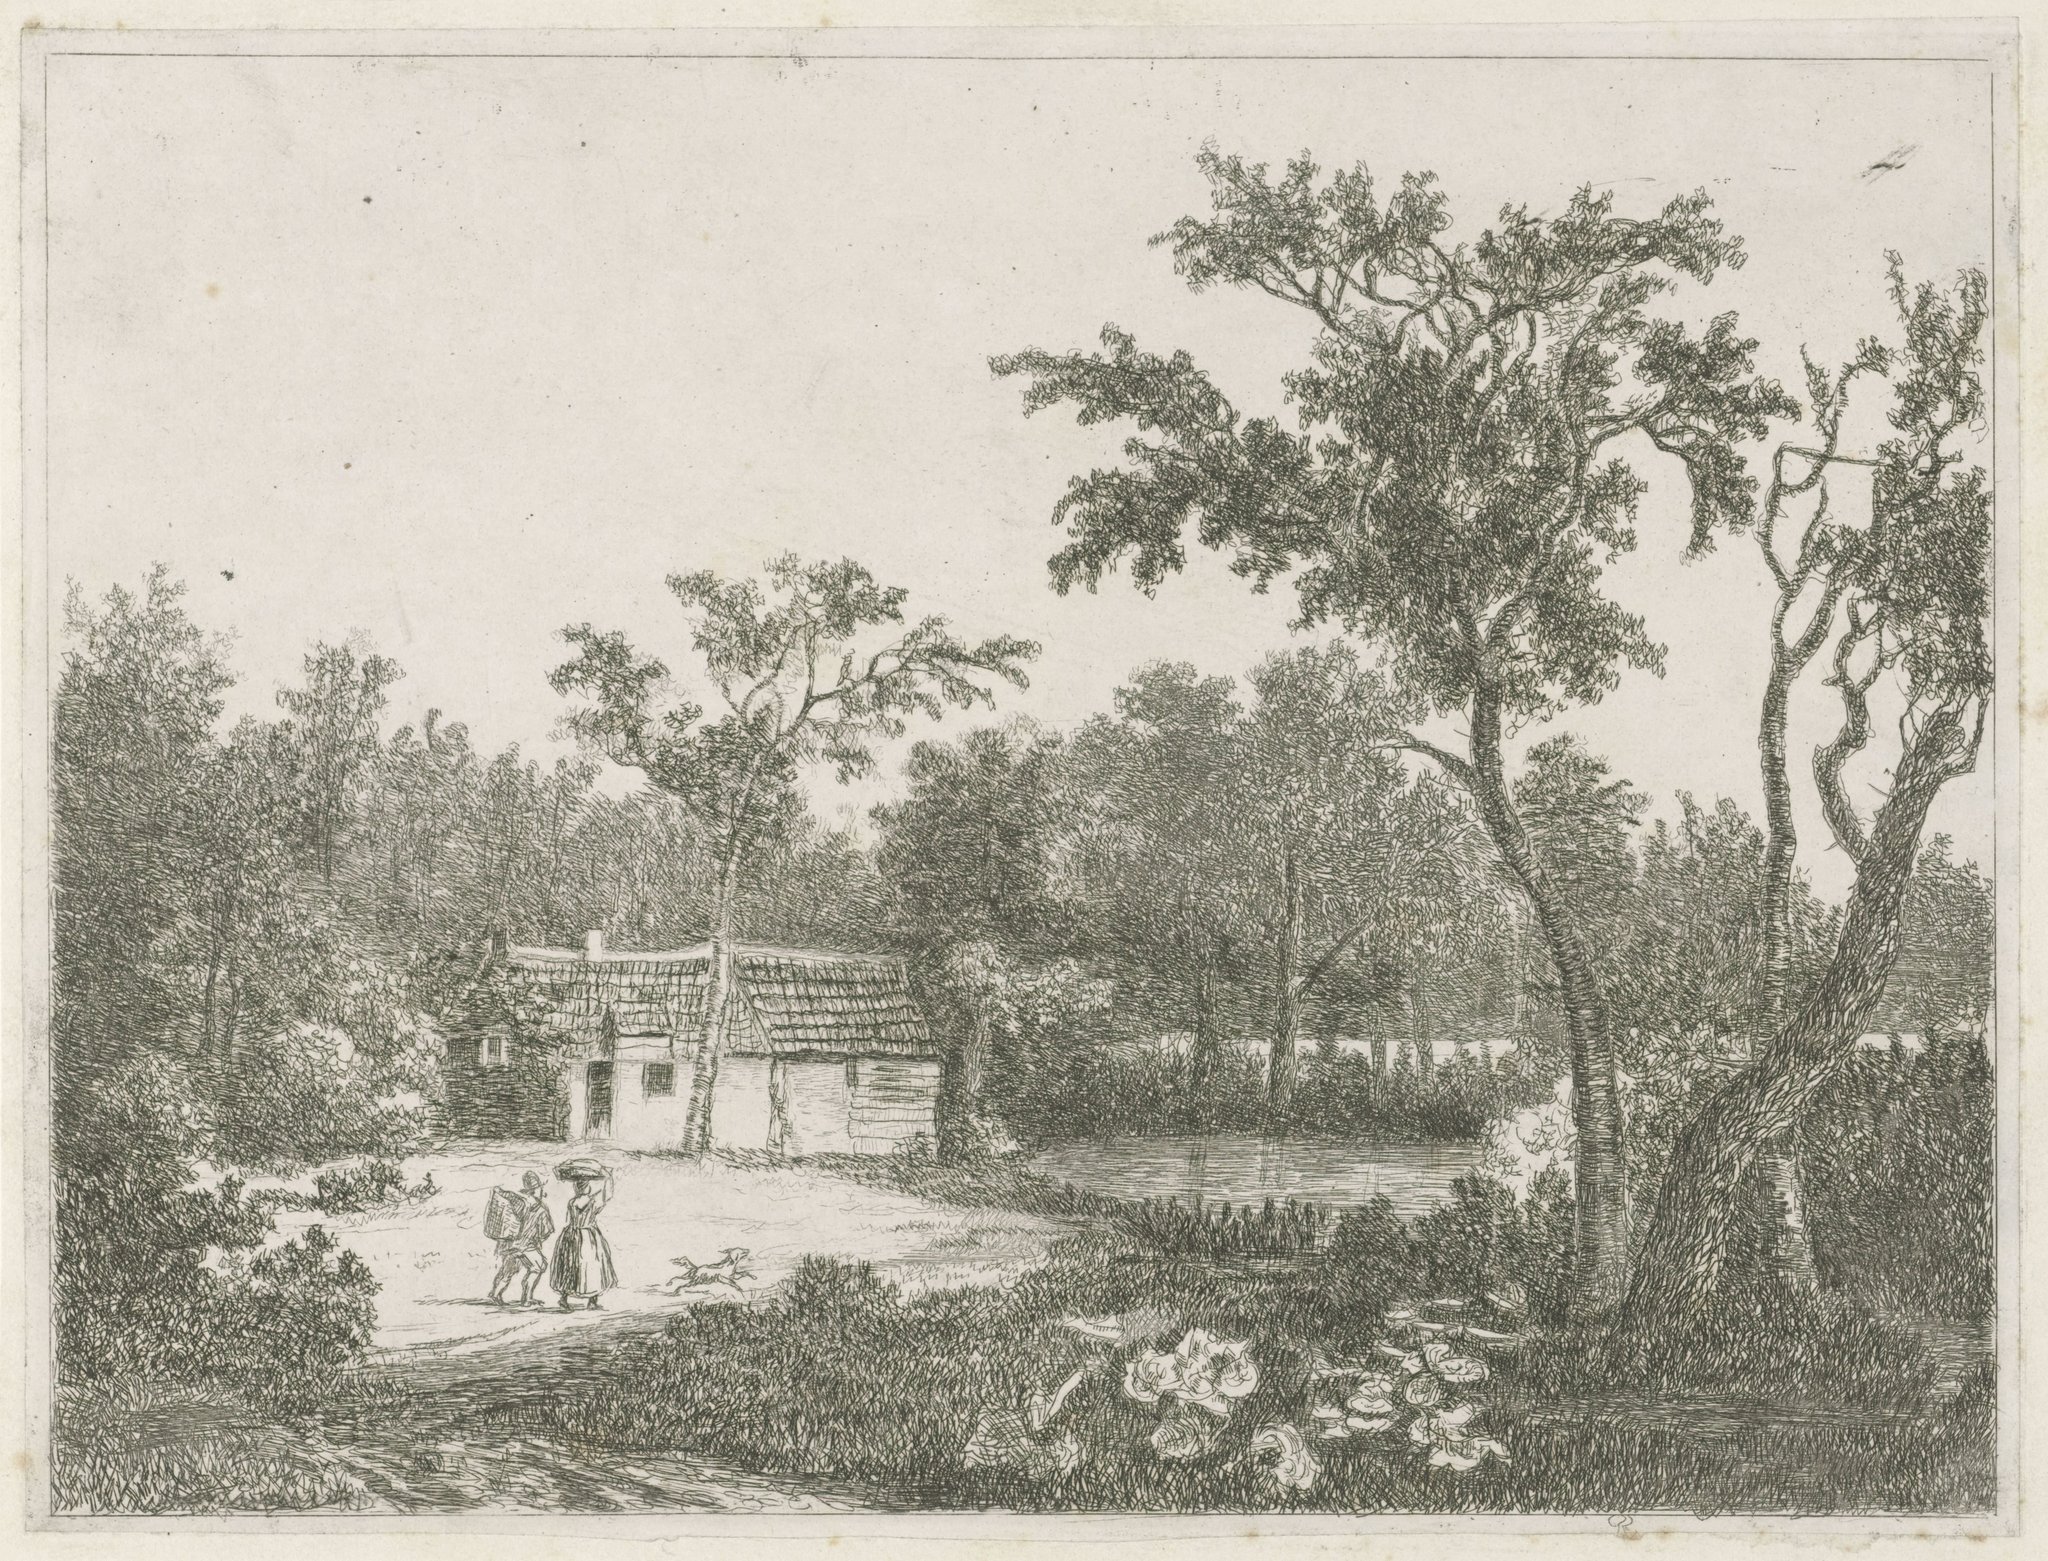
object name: print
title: Man en vrouw bij een huis aan het water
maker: hermanus jan hendrik van rijkelijkhuysen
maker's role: painter, print maker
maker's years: 1813-1883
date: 1823-1883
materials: paper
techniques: etching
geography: utrecht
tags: rural housing, e.g. country-house, villa, cottage (+ variant), lake, forest, wood, glade, 'lichtung im wald', dog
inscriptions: collector's mark: Lugt 1485, collector's mark: Lugt 2228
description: Gezicht op een open plek in het bos met een meer waar een huis naast ligt. Op de voorgrond een man en een vrouw met een hond.